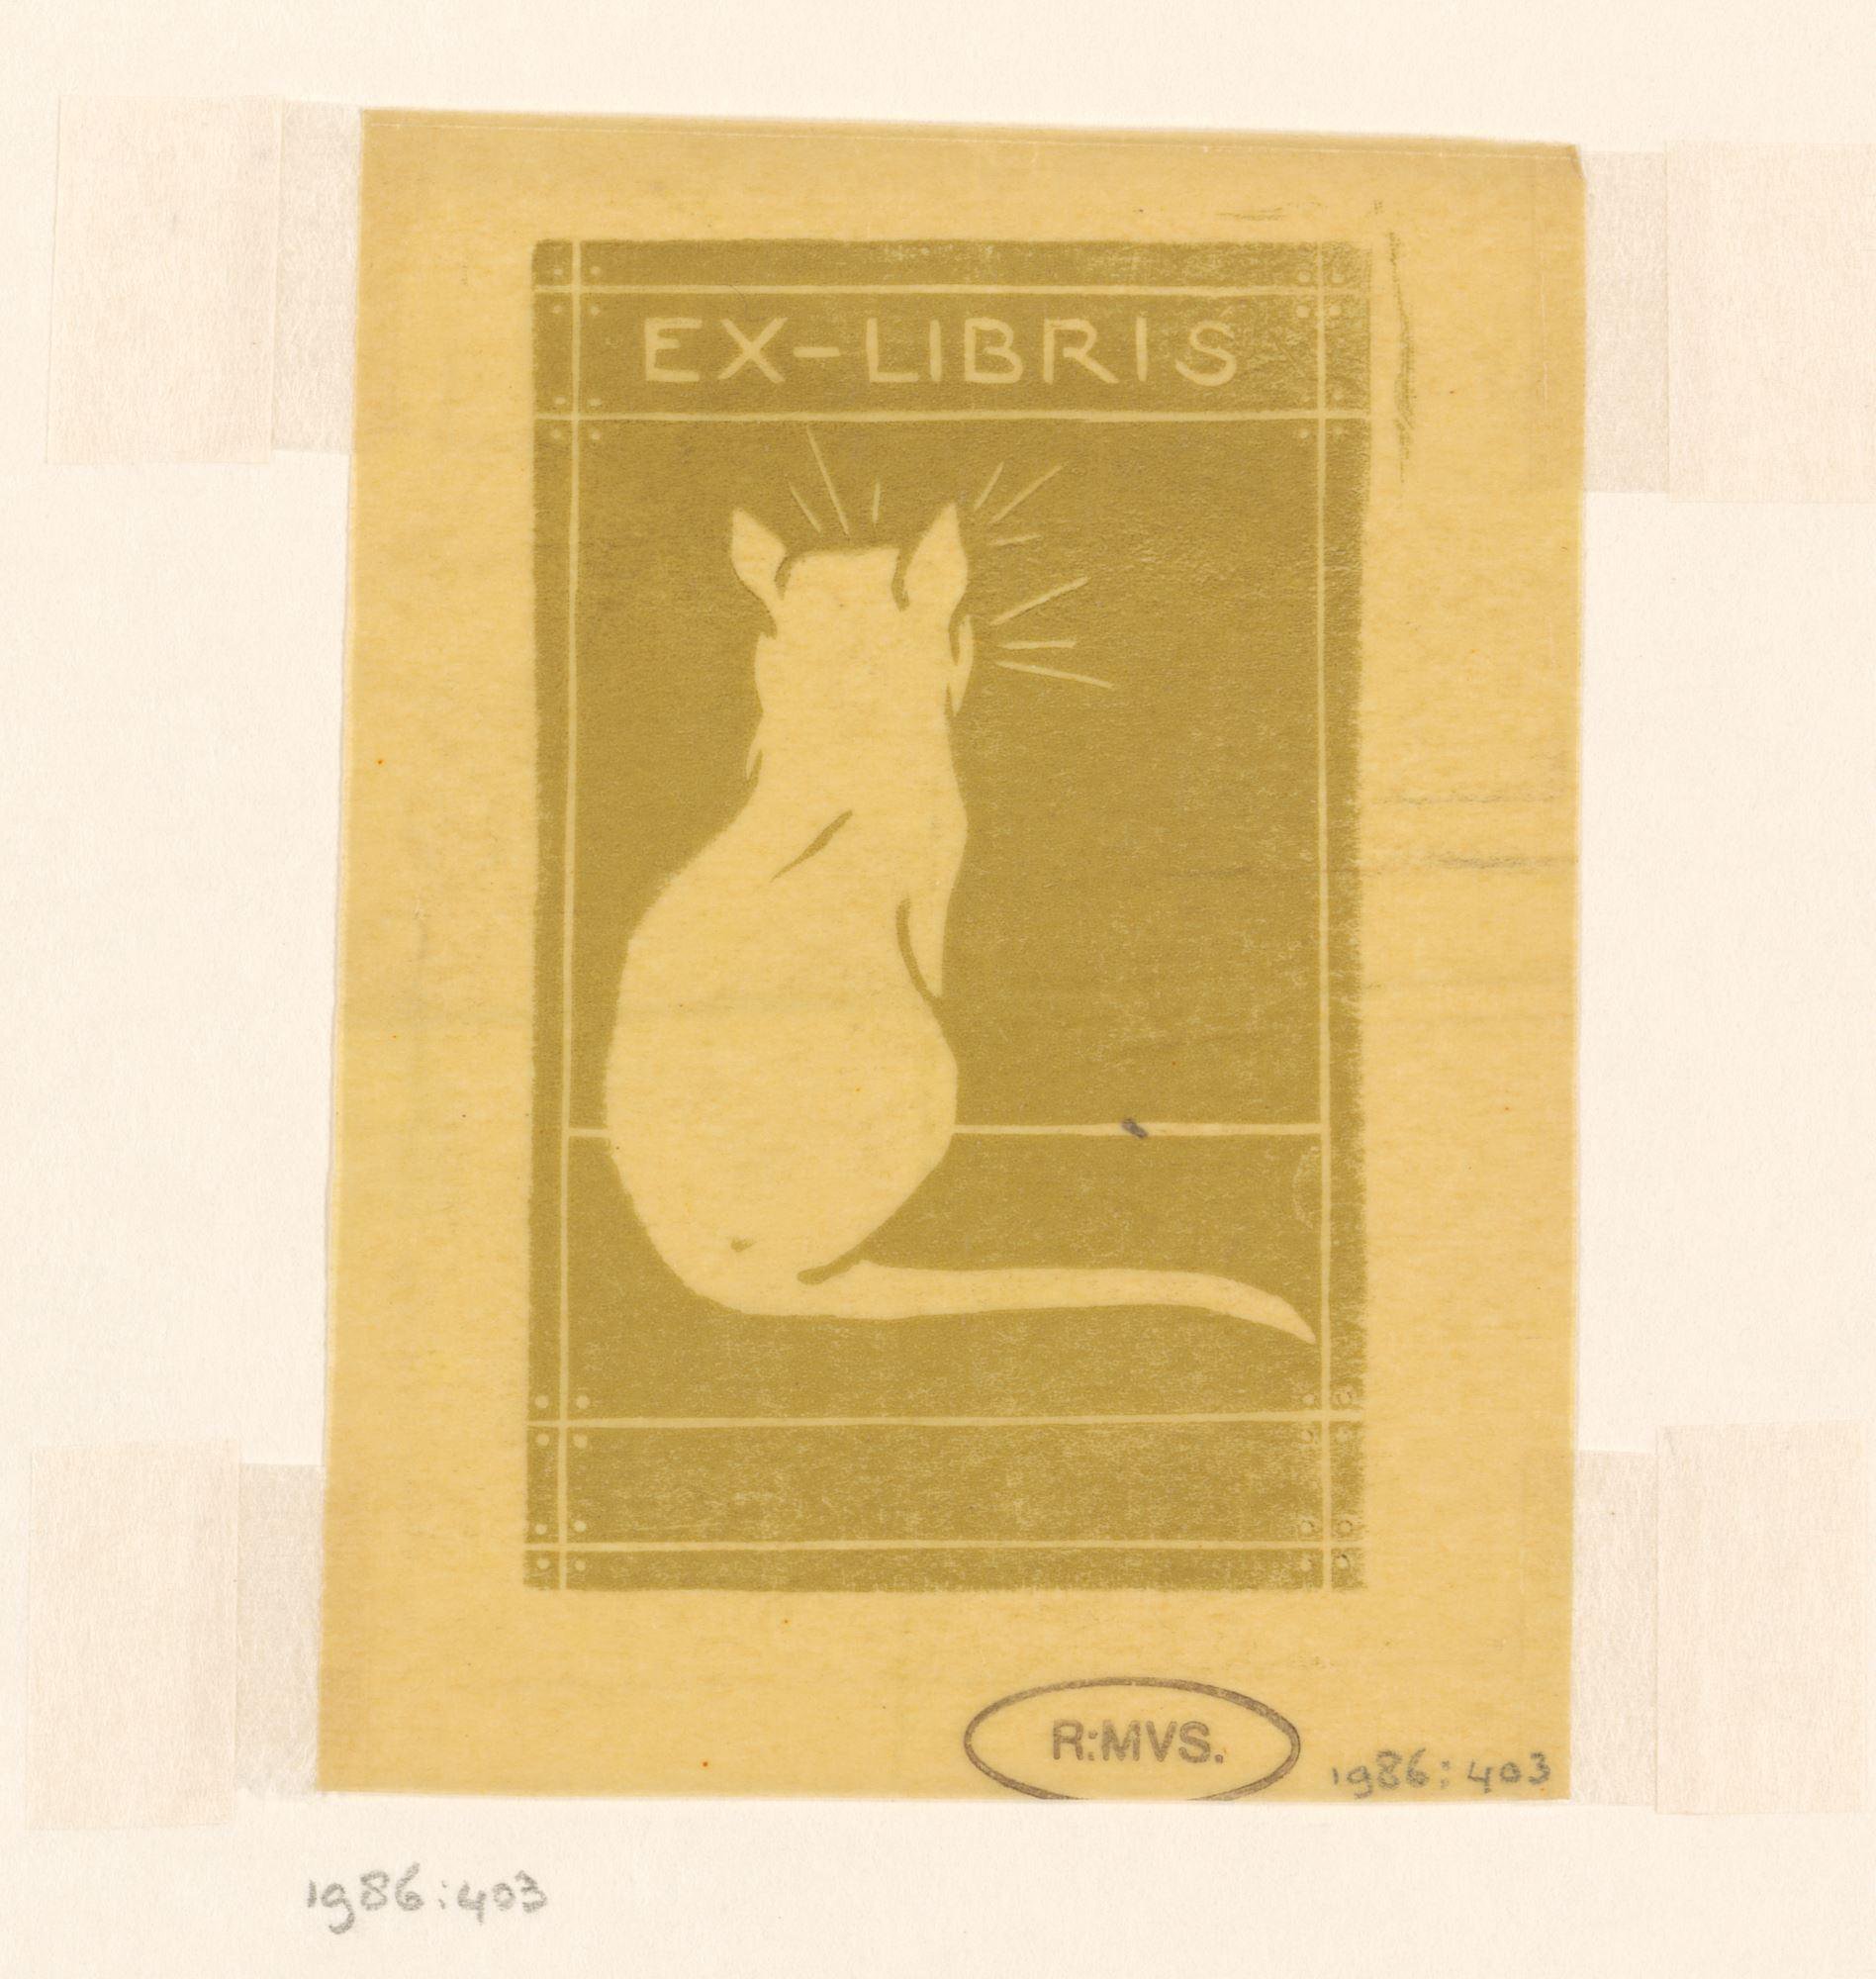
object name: bookplate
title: Ex libris met kat op de rug gezien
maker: reinier willem petrus de vries (1874-1953)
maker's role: draughtsman, print maker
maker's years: 1874-1953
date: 1884-1952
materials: paper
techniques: linocut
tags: cat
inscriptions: collector's mark: Lugt 2228